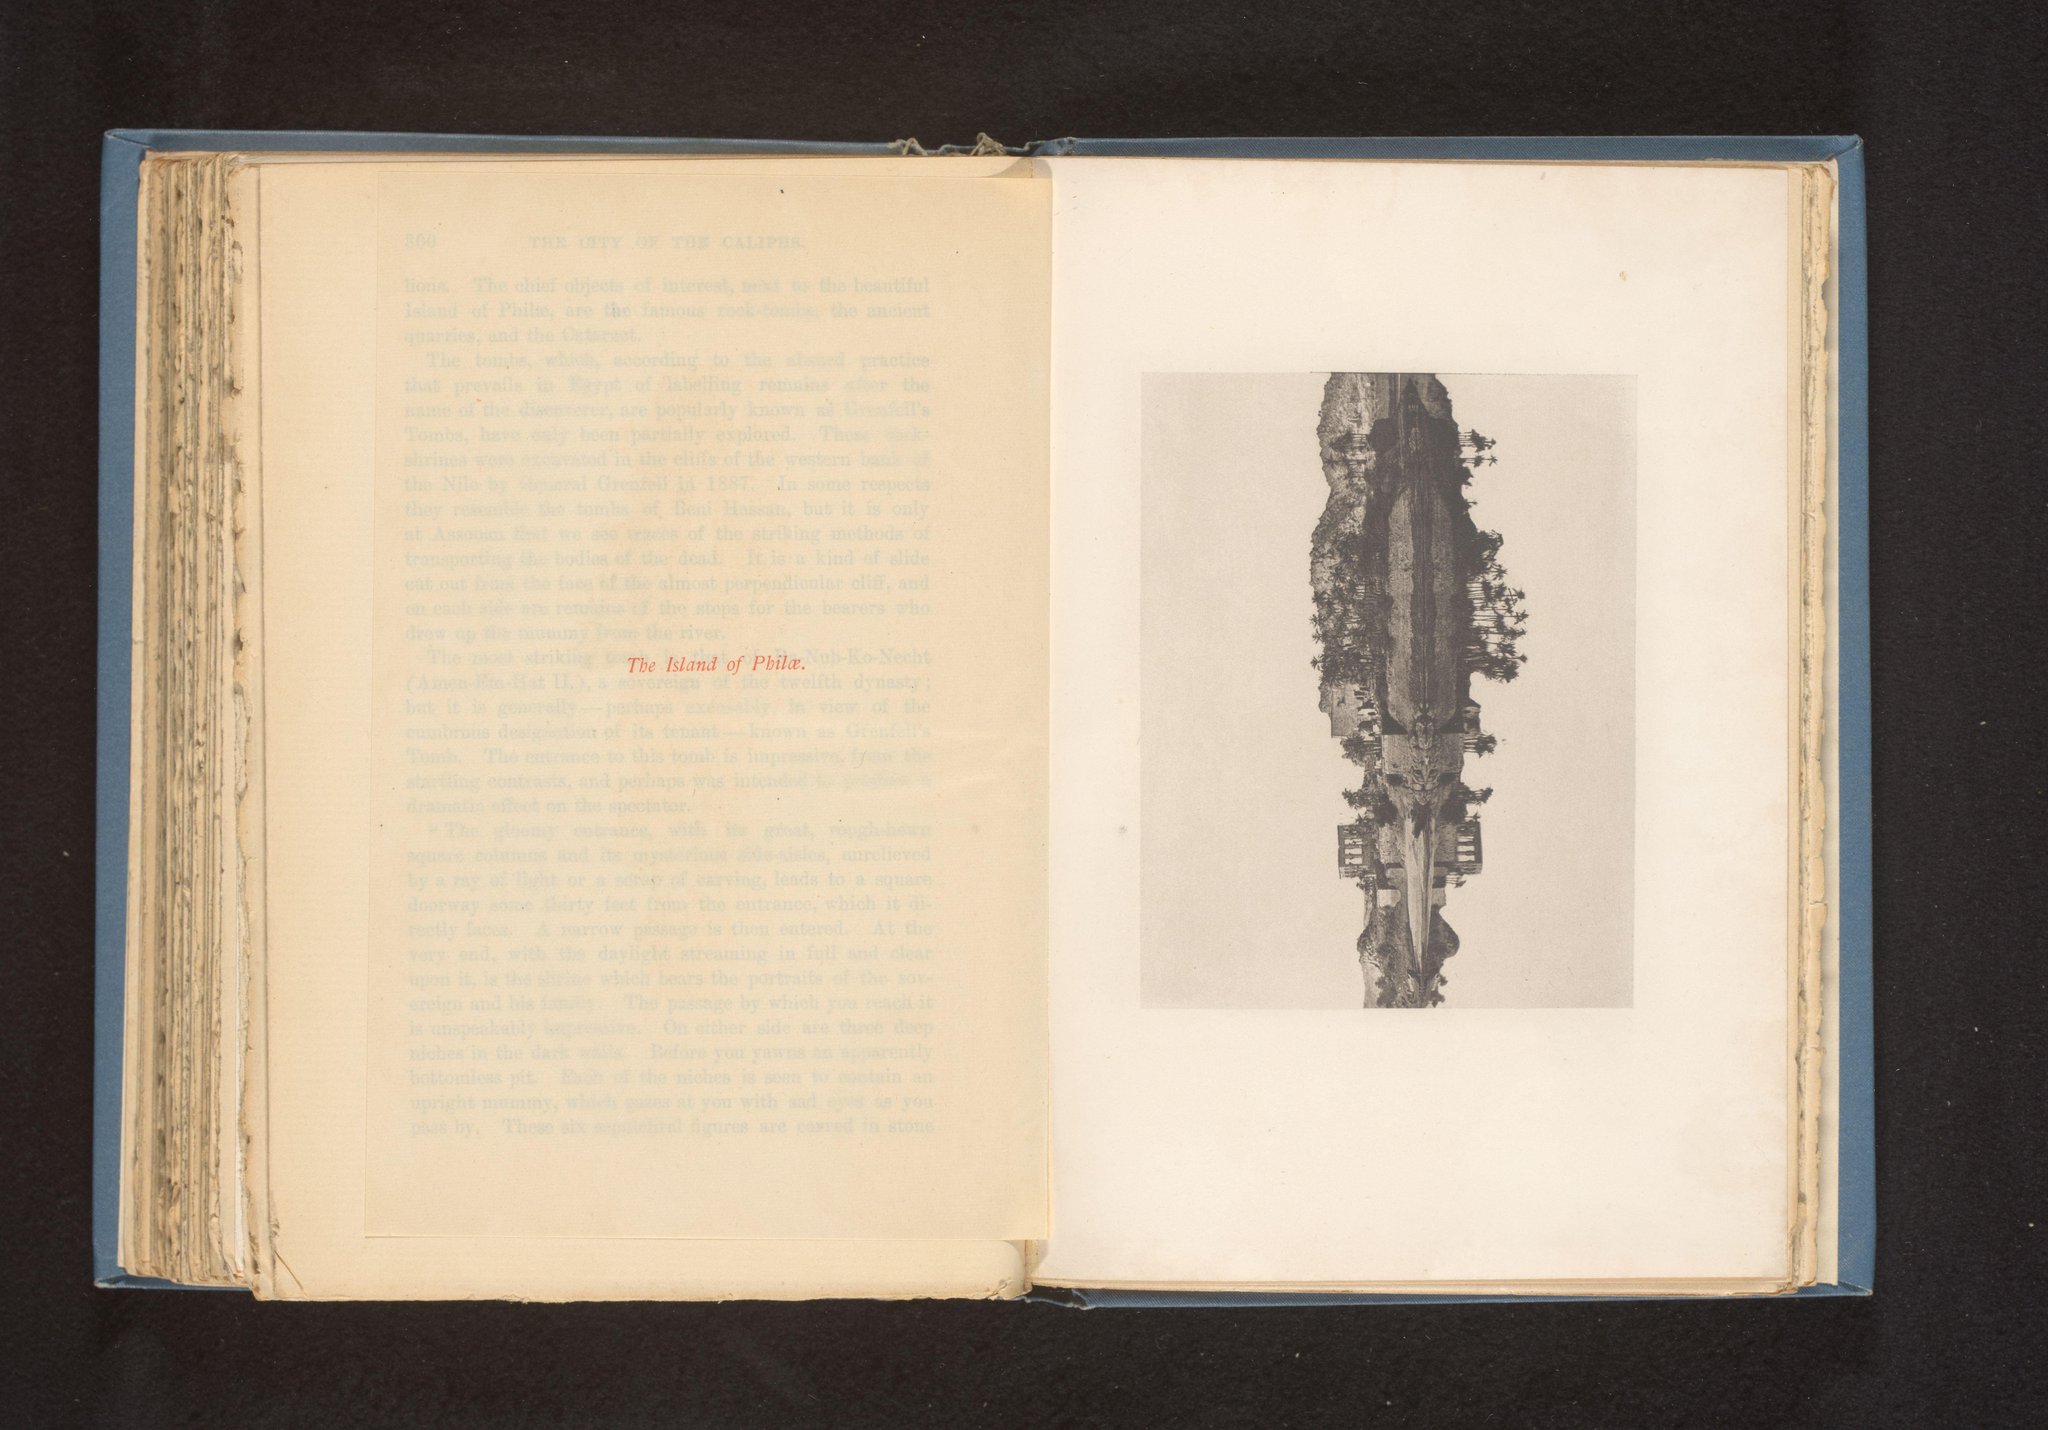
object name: page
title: Gezicht op Philae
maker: Anonymous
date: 1887-1897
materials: paper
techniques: photoaquatint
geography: egypt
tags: island, river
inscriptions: title: ‘The Island of Philae.’